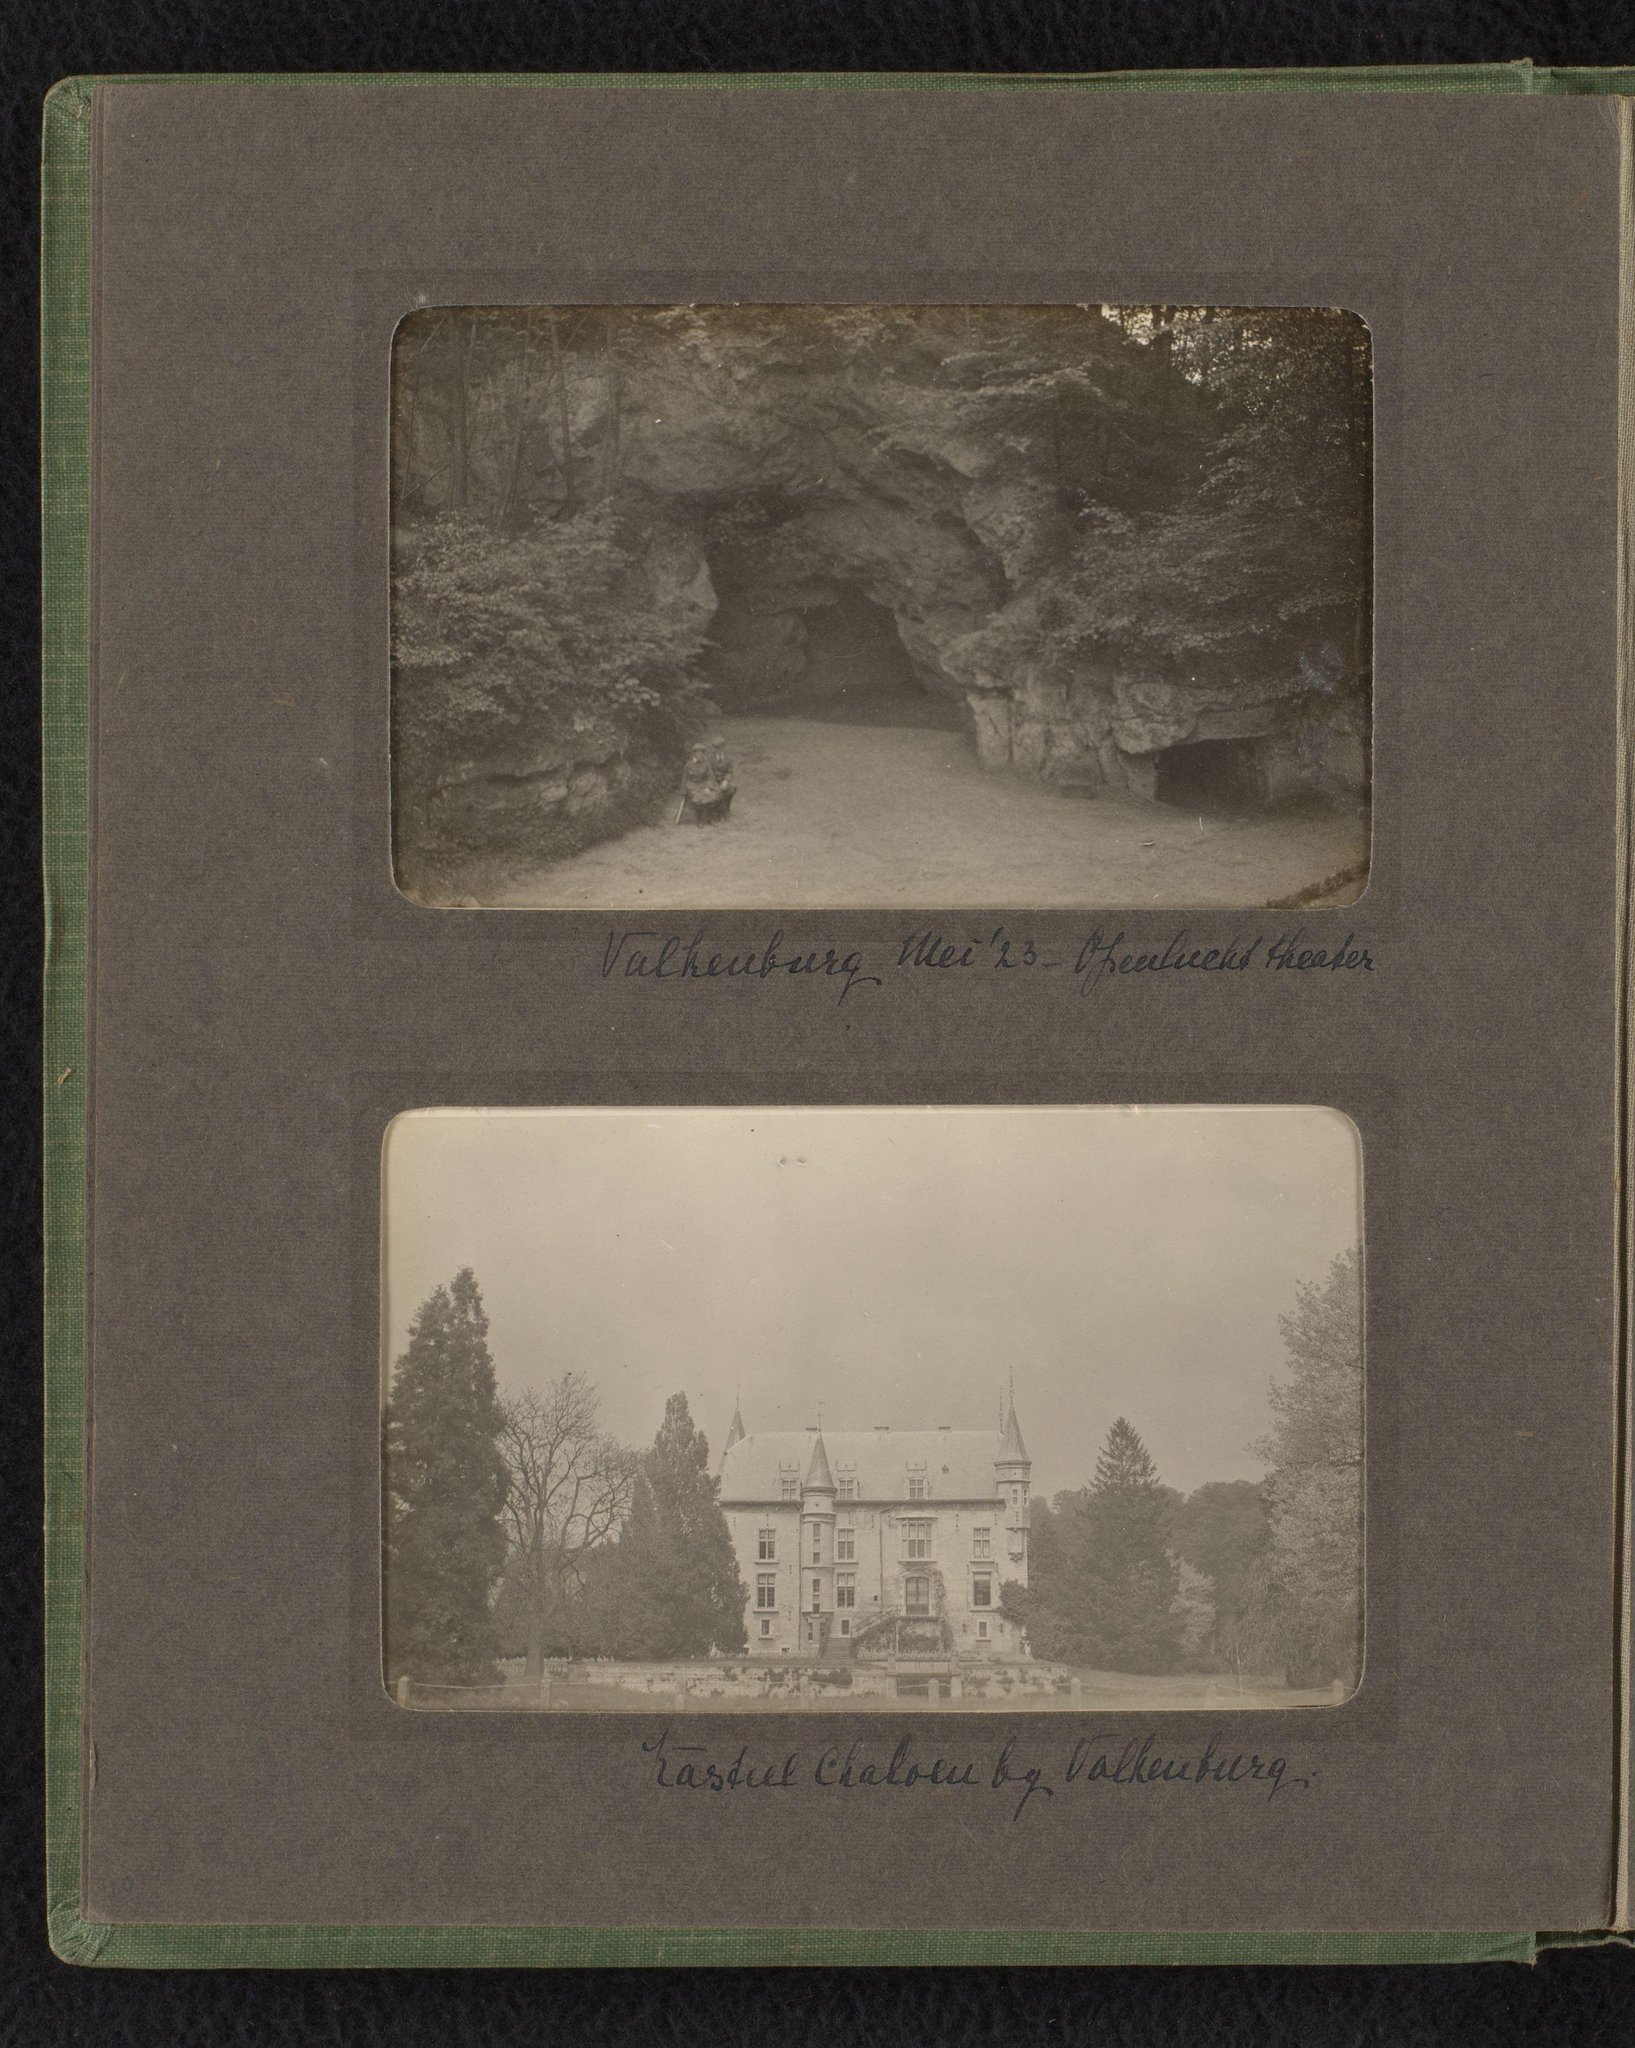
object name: album leaf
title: Twee foto's van de omgeving van Valkenburg, mei 1923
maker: hendrik herman van den berg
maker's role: amateurfotograaf, jurist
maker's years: 1875-1944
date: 1905-1923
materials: paper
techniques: gelatin silver print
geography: valkenburg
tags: castle, cave, grotto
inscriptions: inscription: ‘Kasteel Chaloen bij Valkenburg’, inscription: ‘Valkenburg Mei '23 - Openlucht theater’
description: Deze foto's maken deel uit van een album.